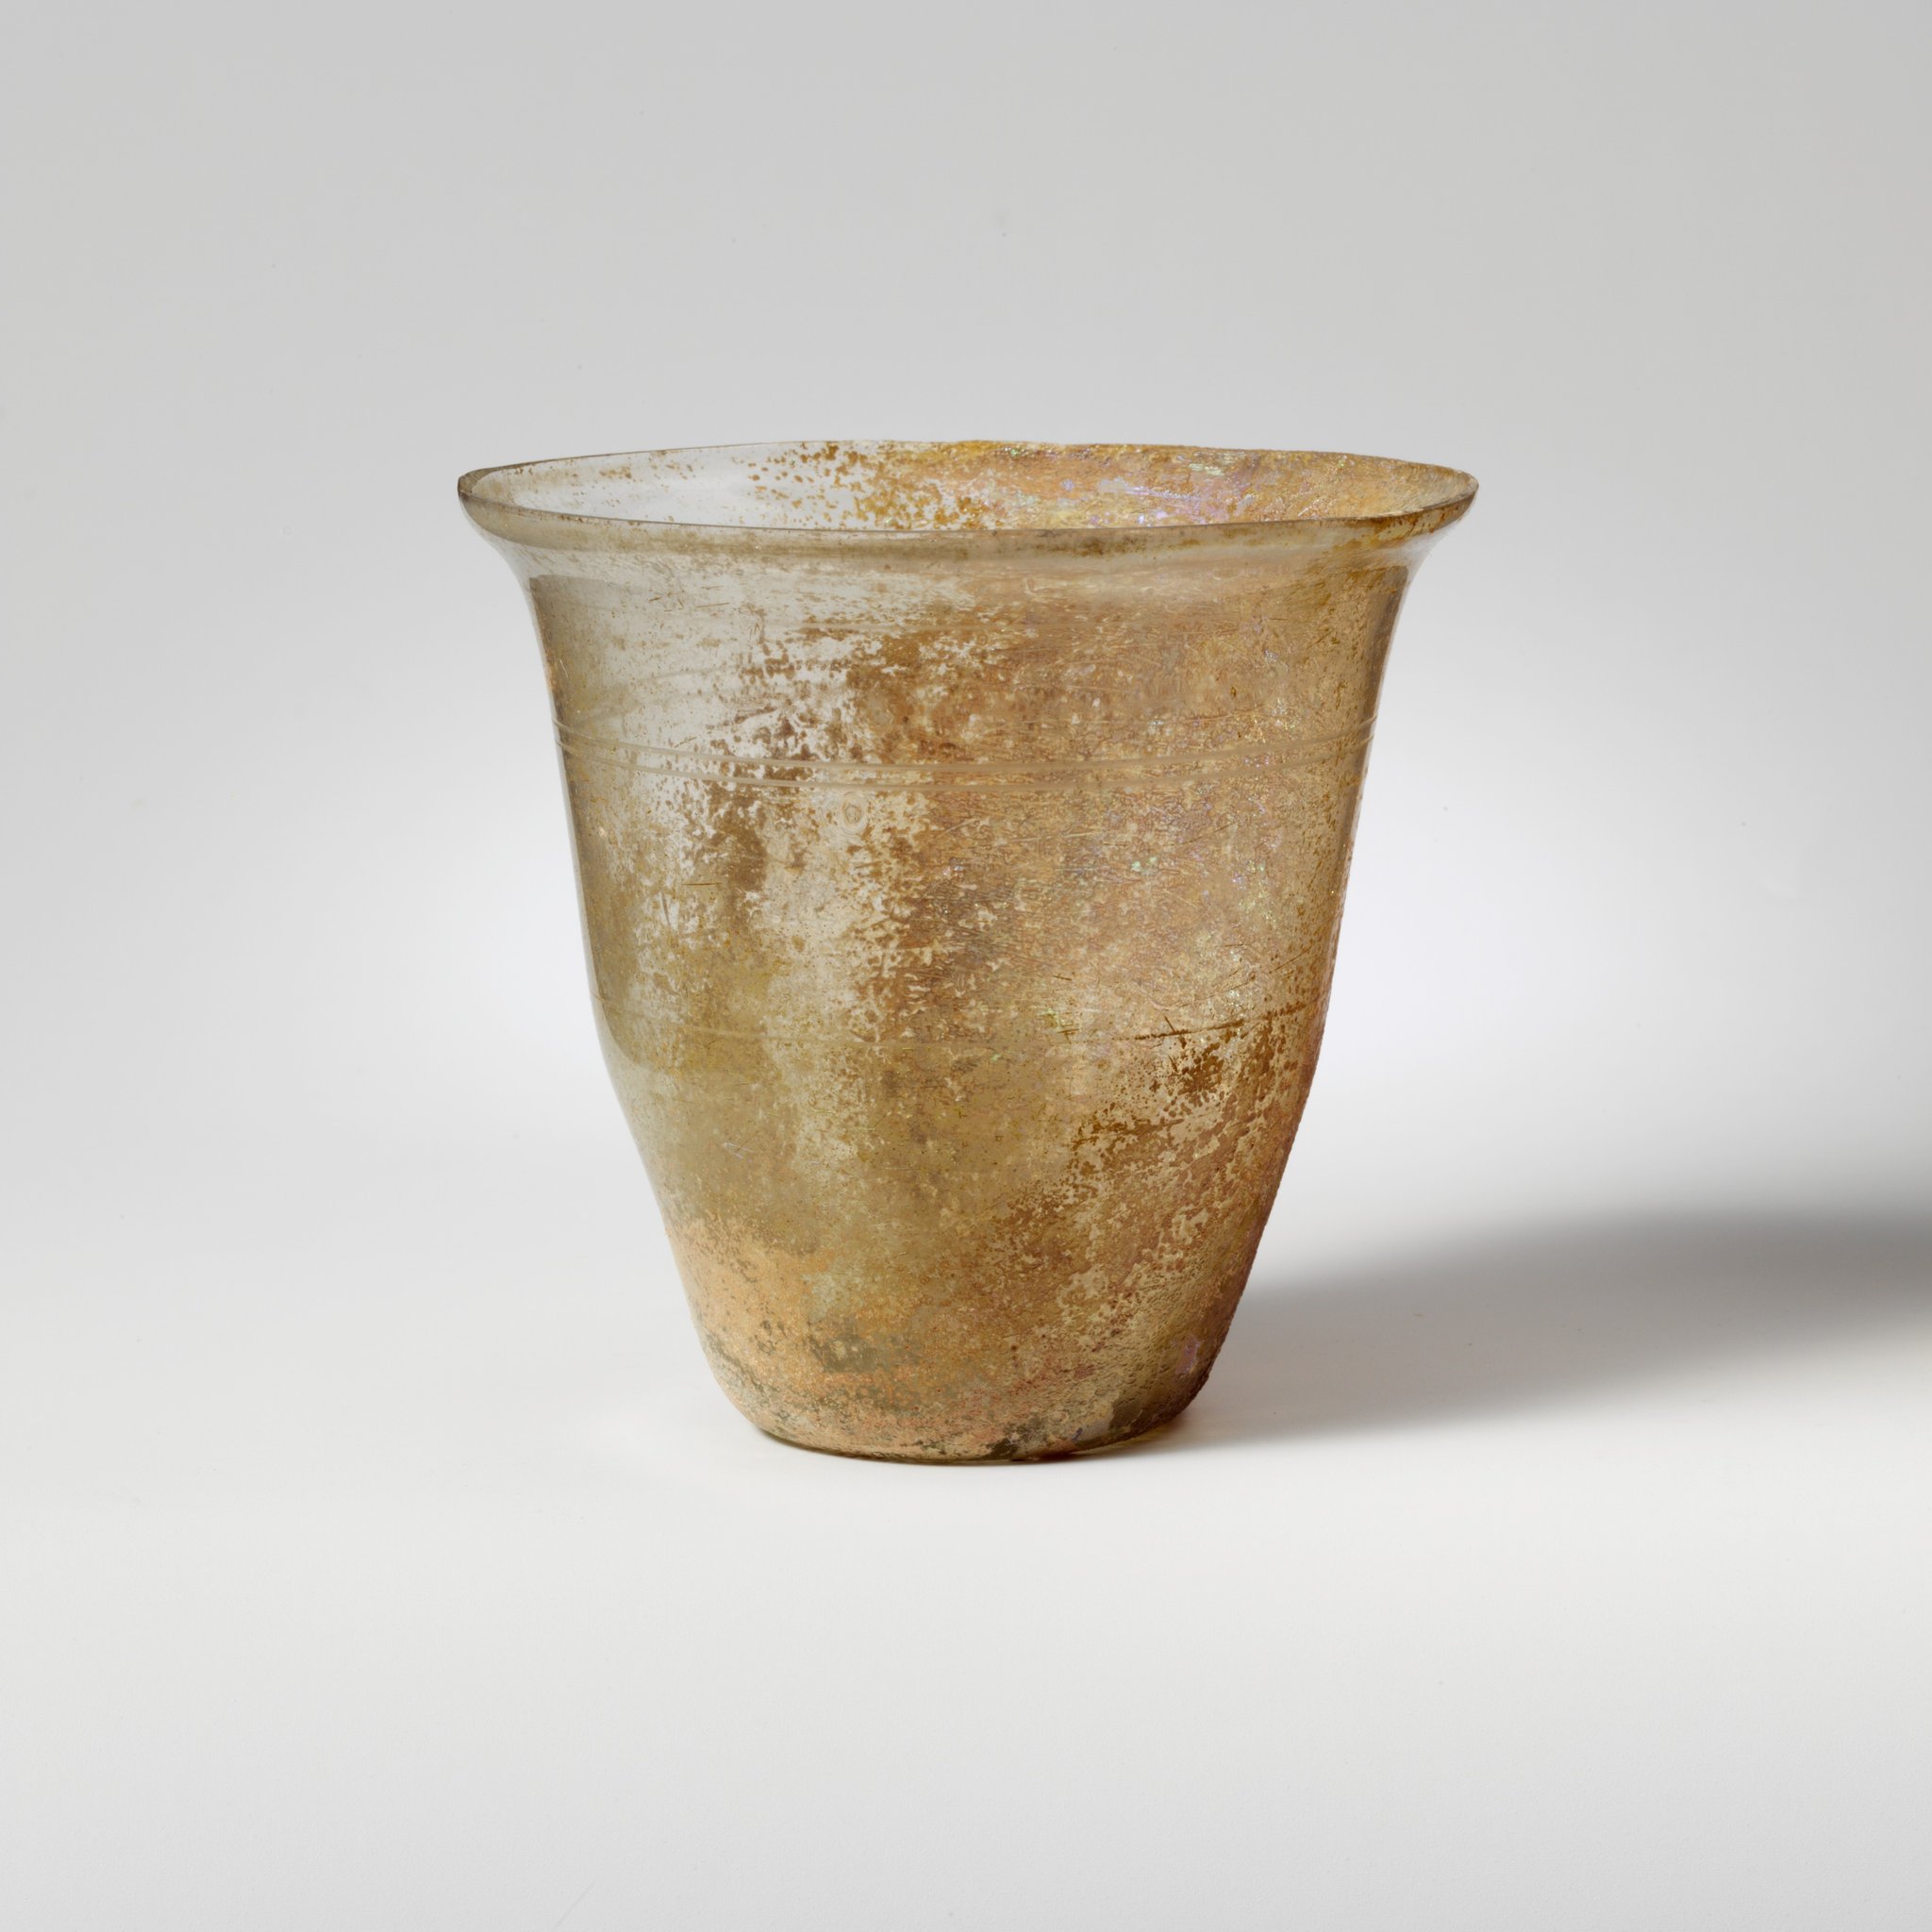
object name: cup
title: Glass cup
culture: roman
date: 1-200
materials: glass